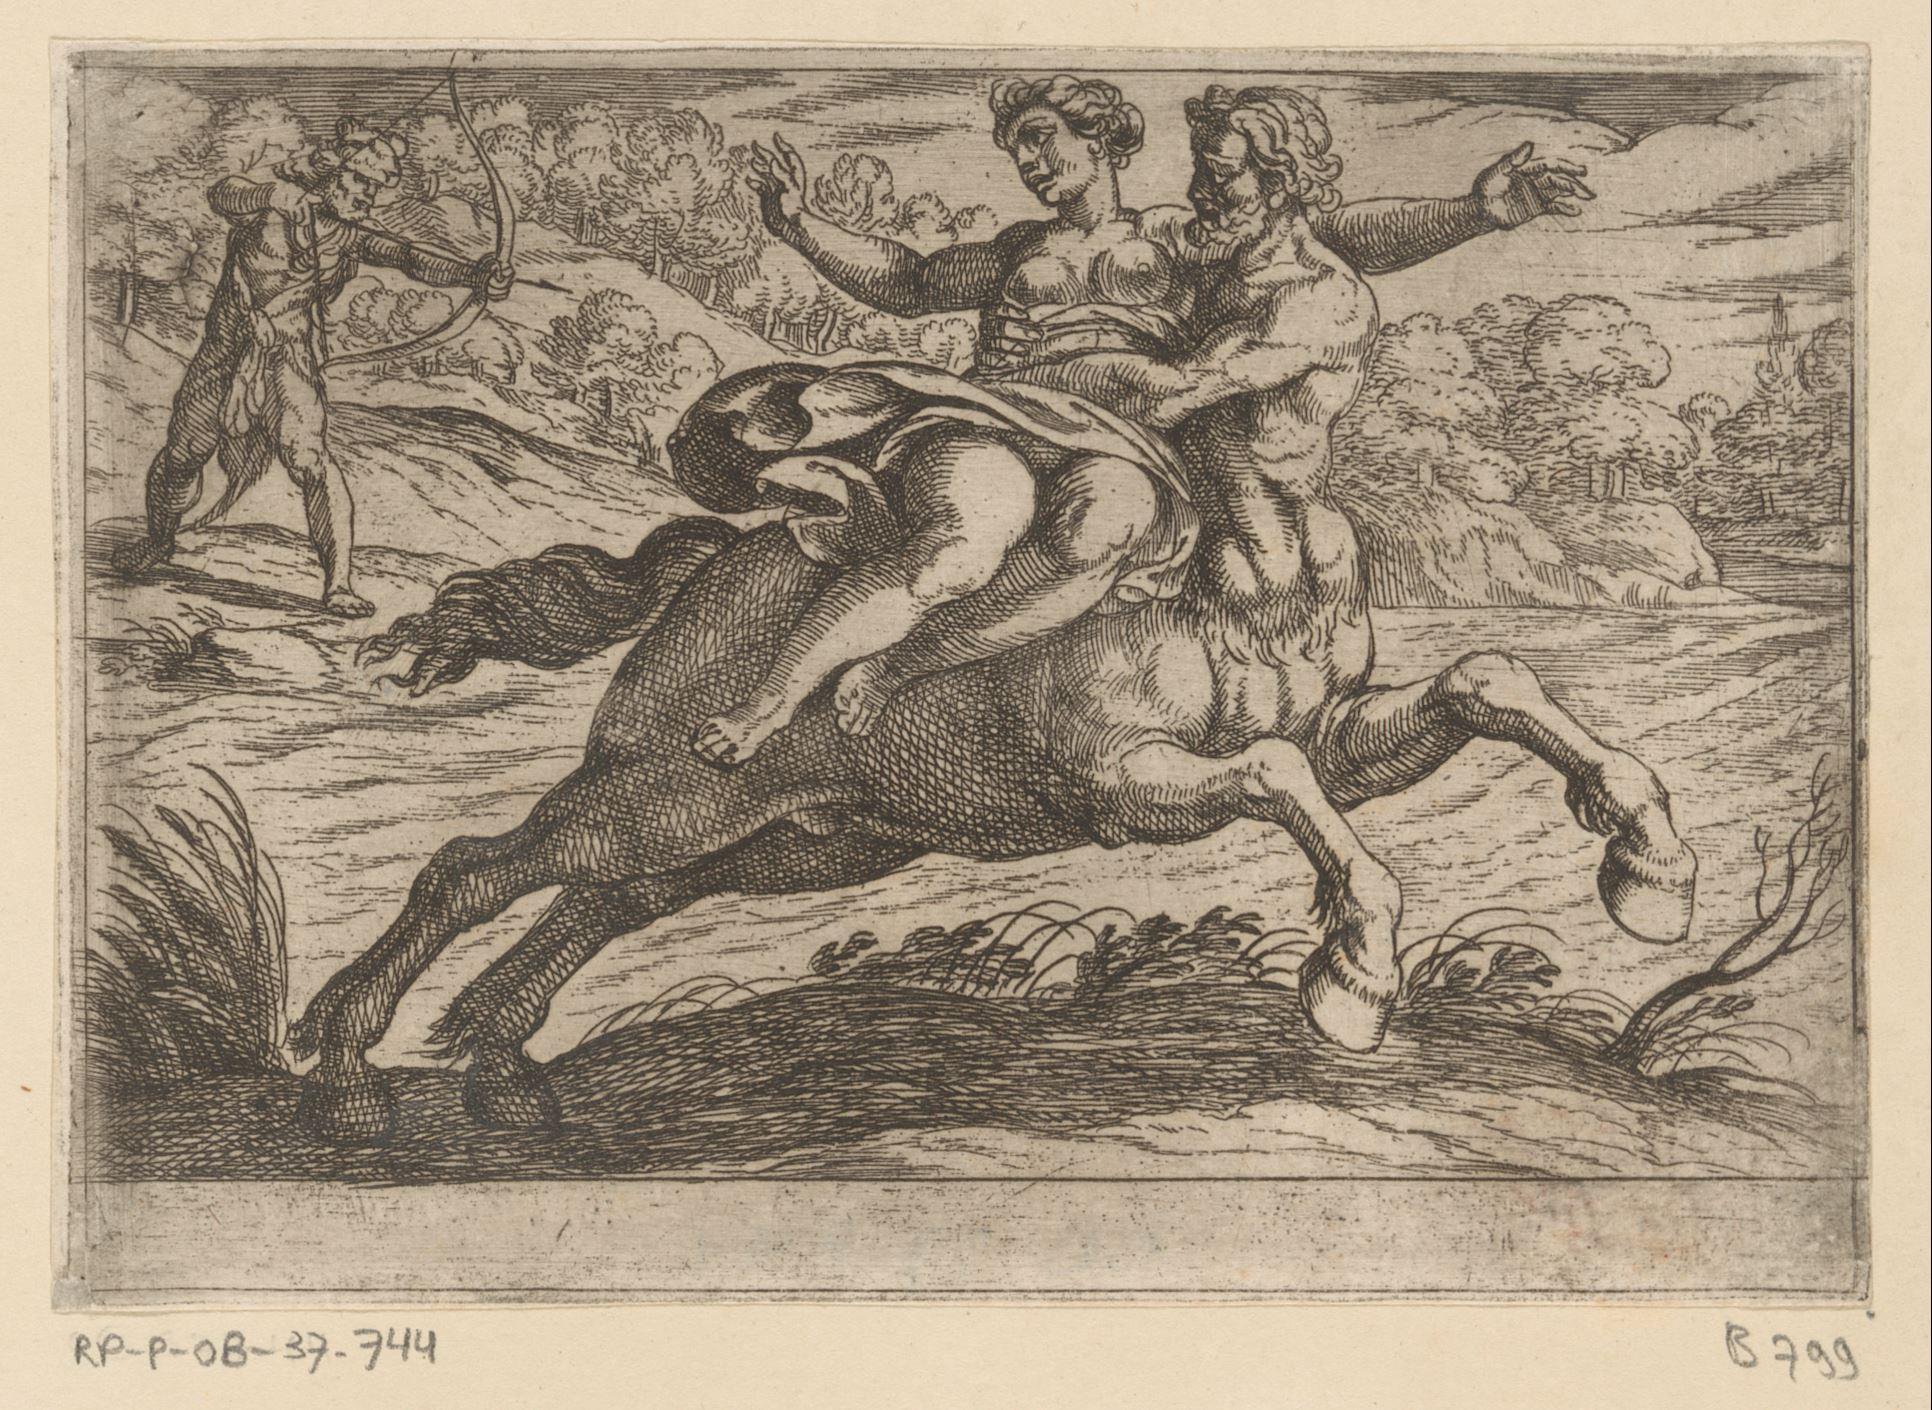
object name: print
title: De twaalf werken van Hercules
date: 1608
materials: paper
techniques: etching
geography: rome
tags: hercules shoots nessus, the centaur, who attempts to carry off deianira, most important deeds of hercules: the twelve labours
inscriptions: collector's mark: Lugt 240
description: De centaur Nessus is veerman bij een rivier. Als hij Deïanira overzet, probeert hij haar te roven en galoppeert hij met haar weg. Hercules die al op de andere oever stond, spant zijn boog om Nessus neer te schieten.